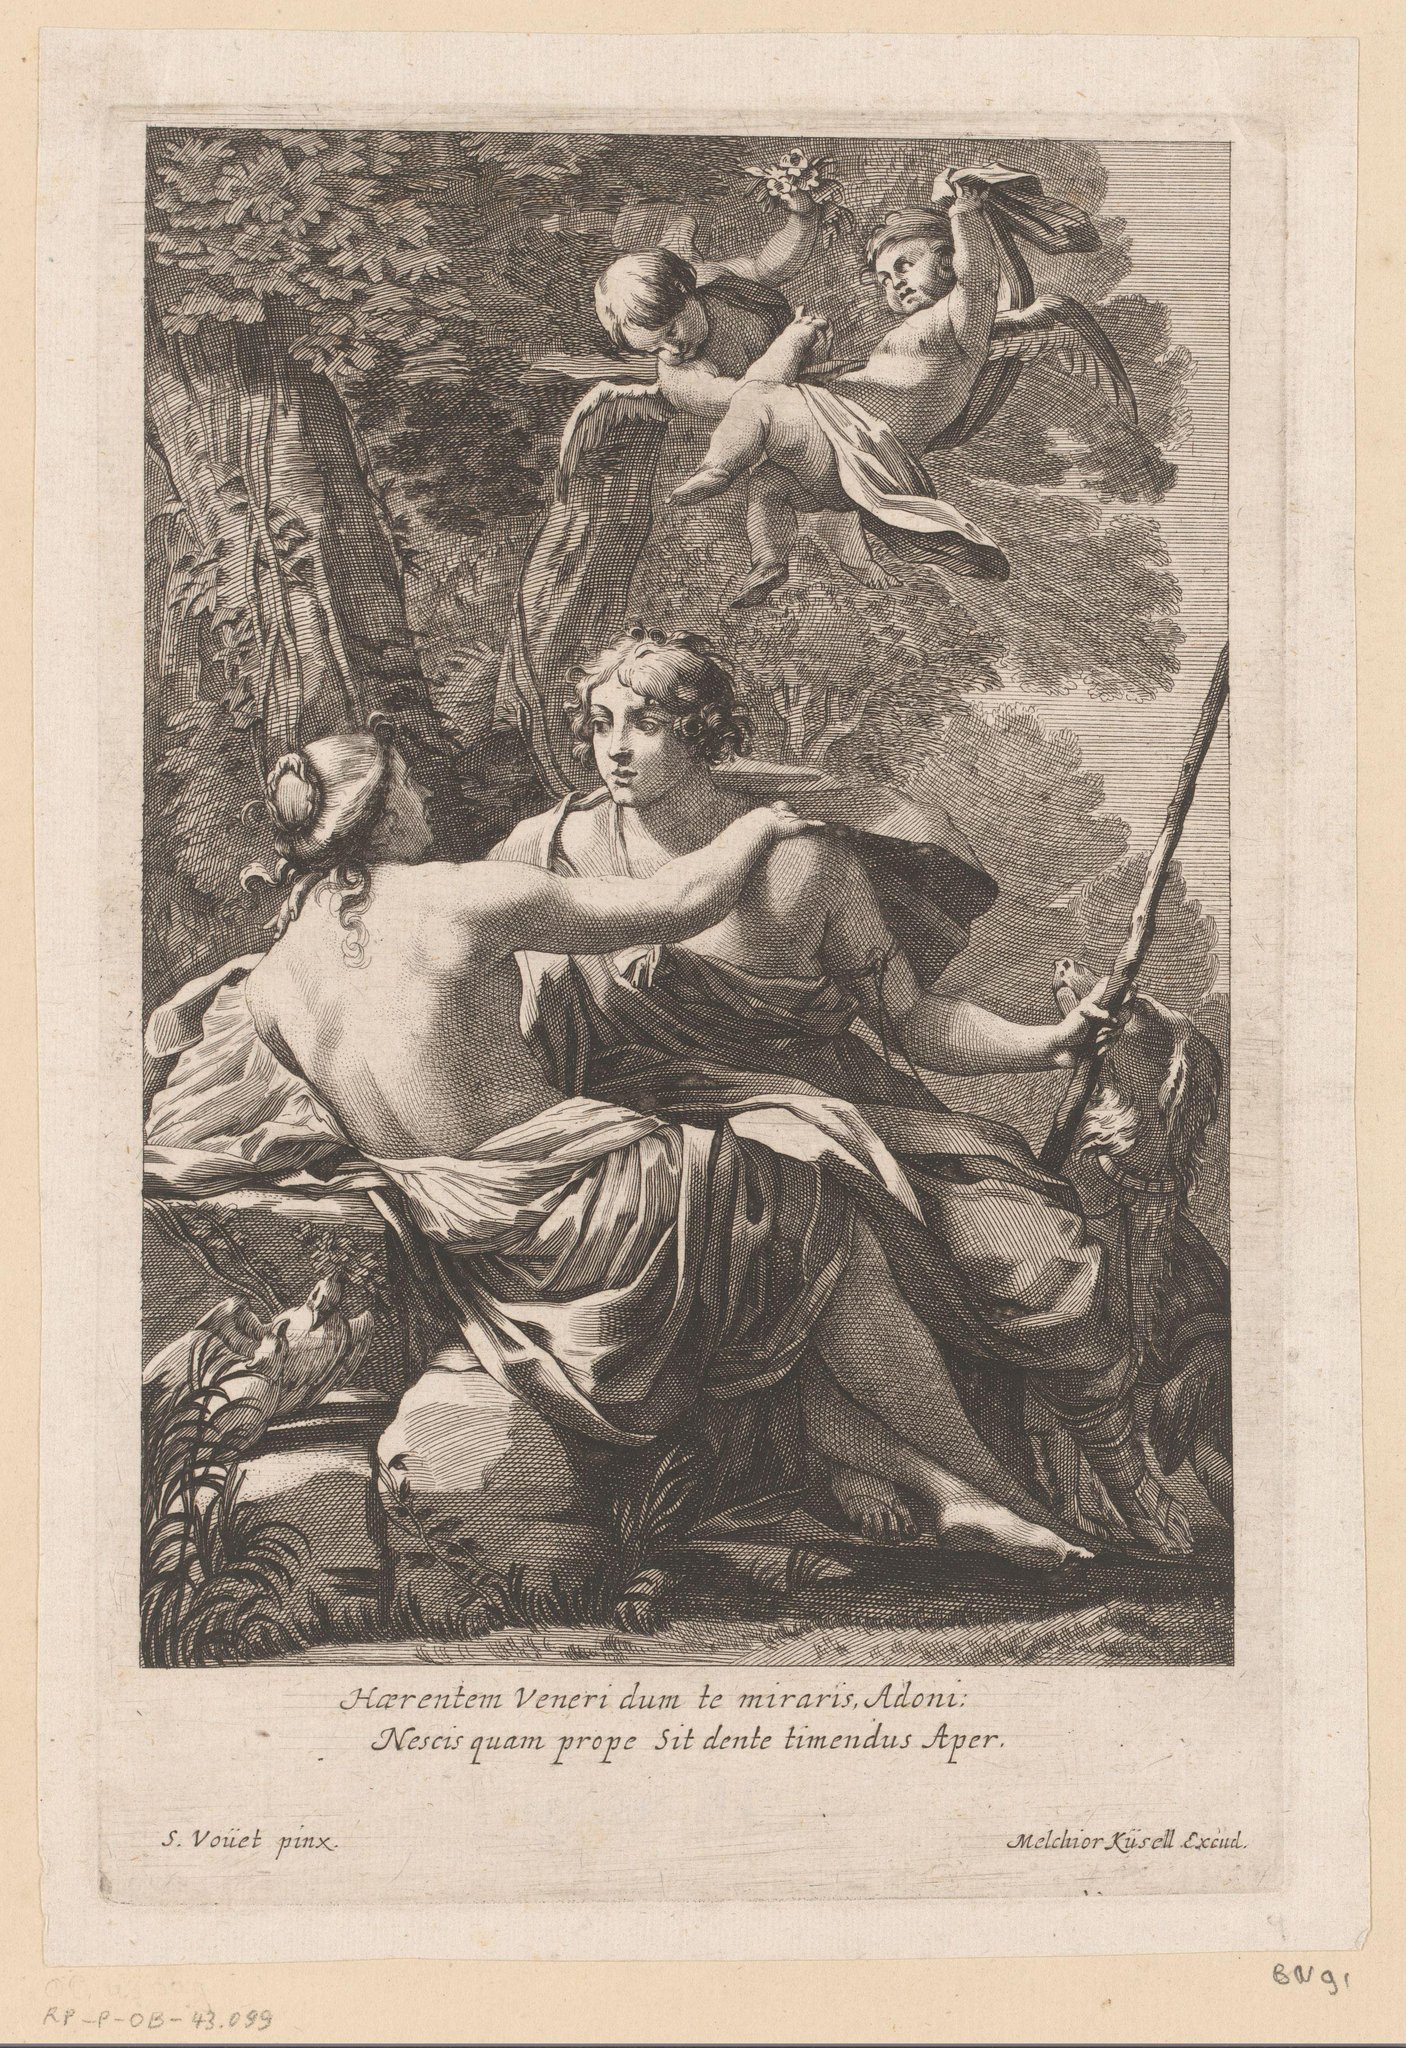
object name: print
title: Venus en Adonis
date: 1643-1683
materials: paper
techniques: engraving, etching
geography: france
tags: venus and adonis as lovers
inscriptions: collector's mark: Lugt 240